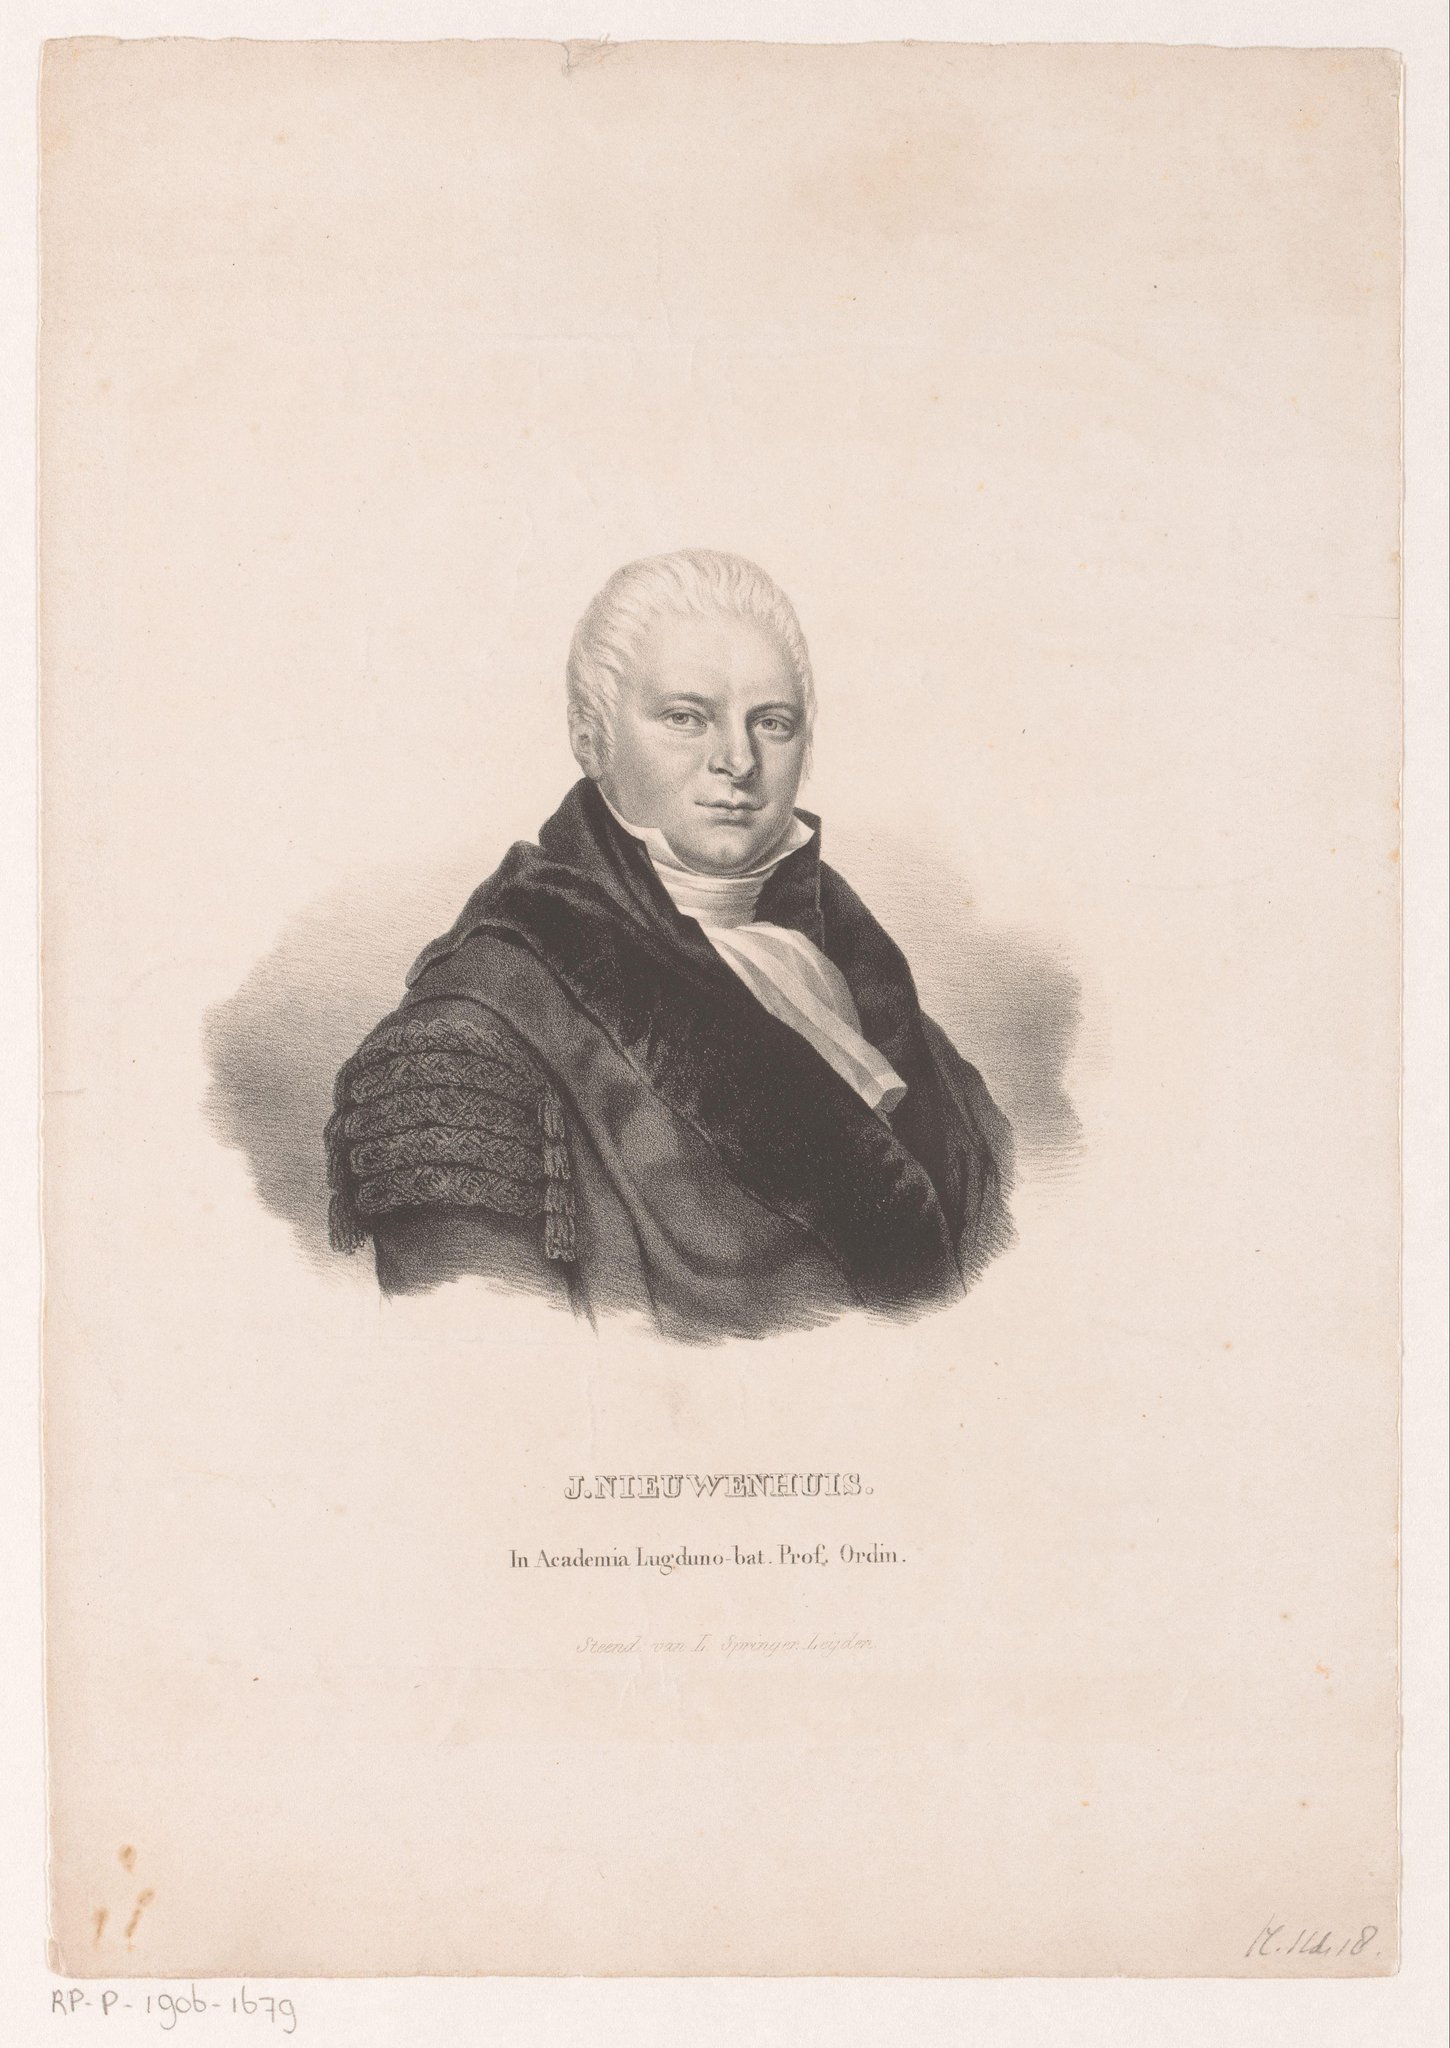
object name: print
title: J. Nieuwenhuis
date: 1809-1871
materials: paper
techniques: lithograph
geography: leiden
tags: historical persons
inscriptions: collector's mark: Lugt 2228